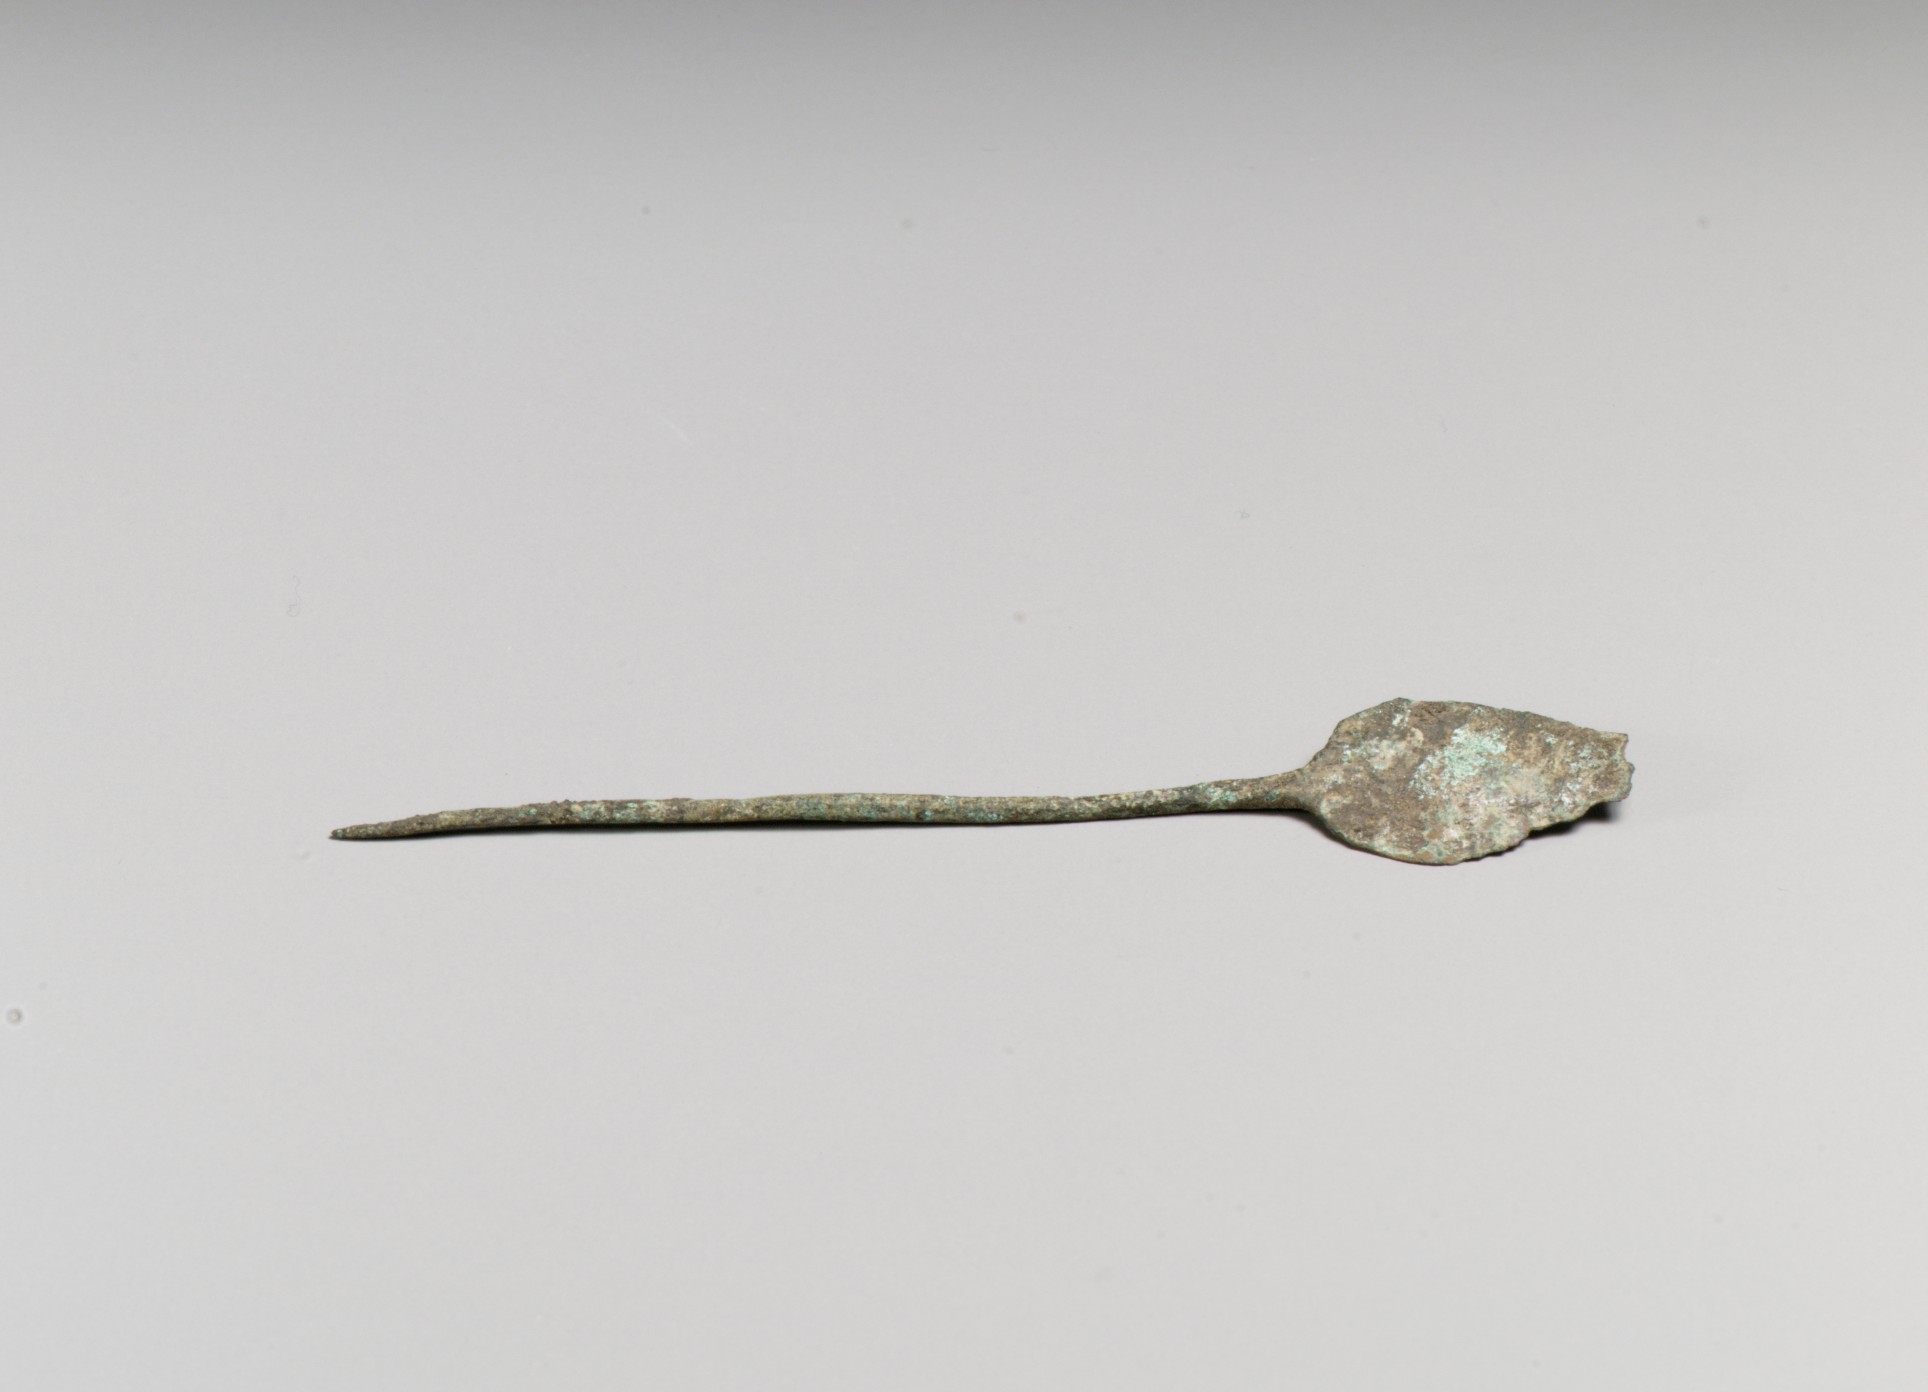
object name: spoon or tongue depressor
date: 7000 BCE-330 CE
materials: bronze